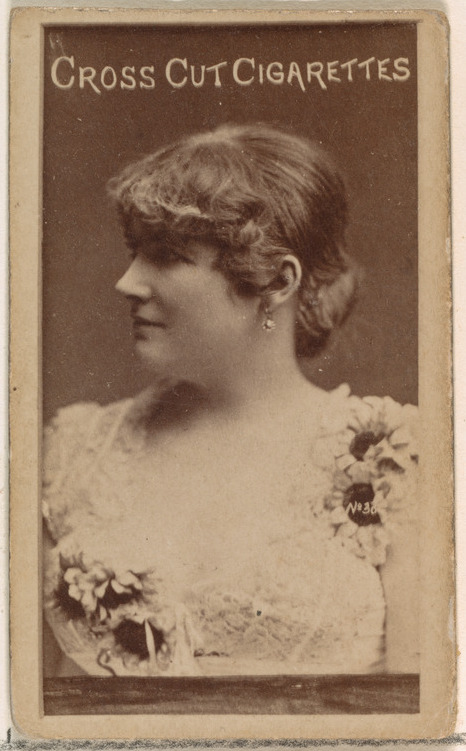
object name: print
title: Card Number 38, from the Actors and Actresses series (N145-1) issued by Duke Sons & Co. to promote Cross Cut Cigarettes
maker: w. duke, sons & co.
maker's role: publisher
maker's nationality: american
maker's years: 1870-1920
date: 1880-1889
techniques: albumen silver print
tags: profiles,women,actresses